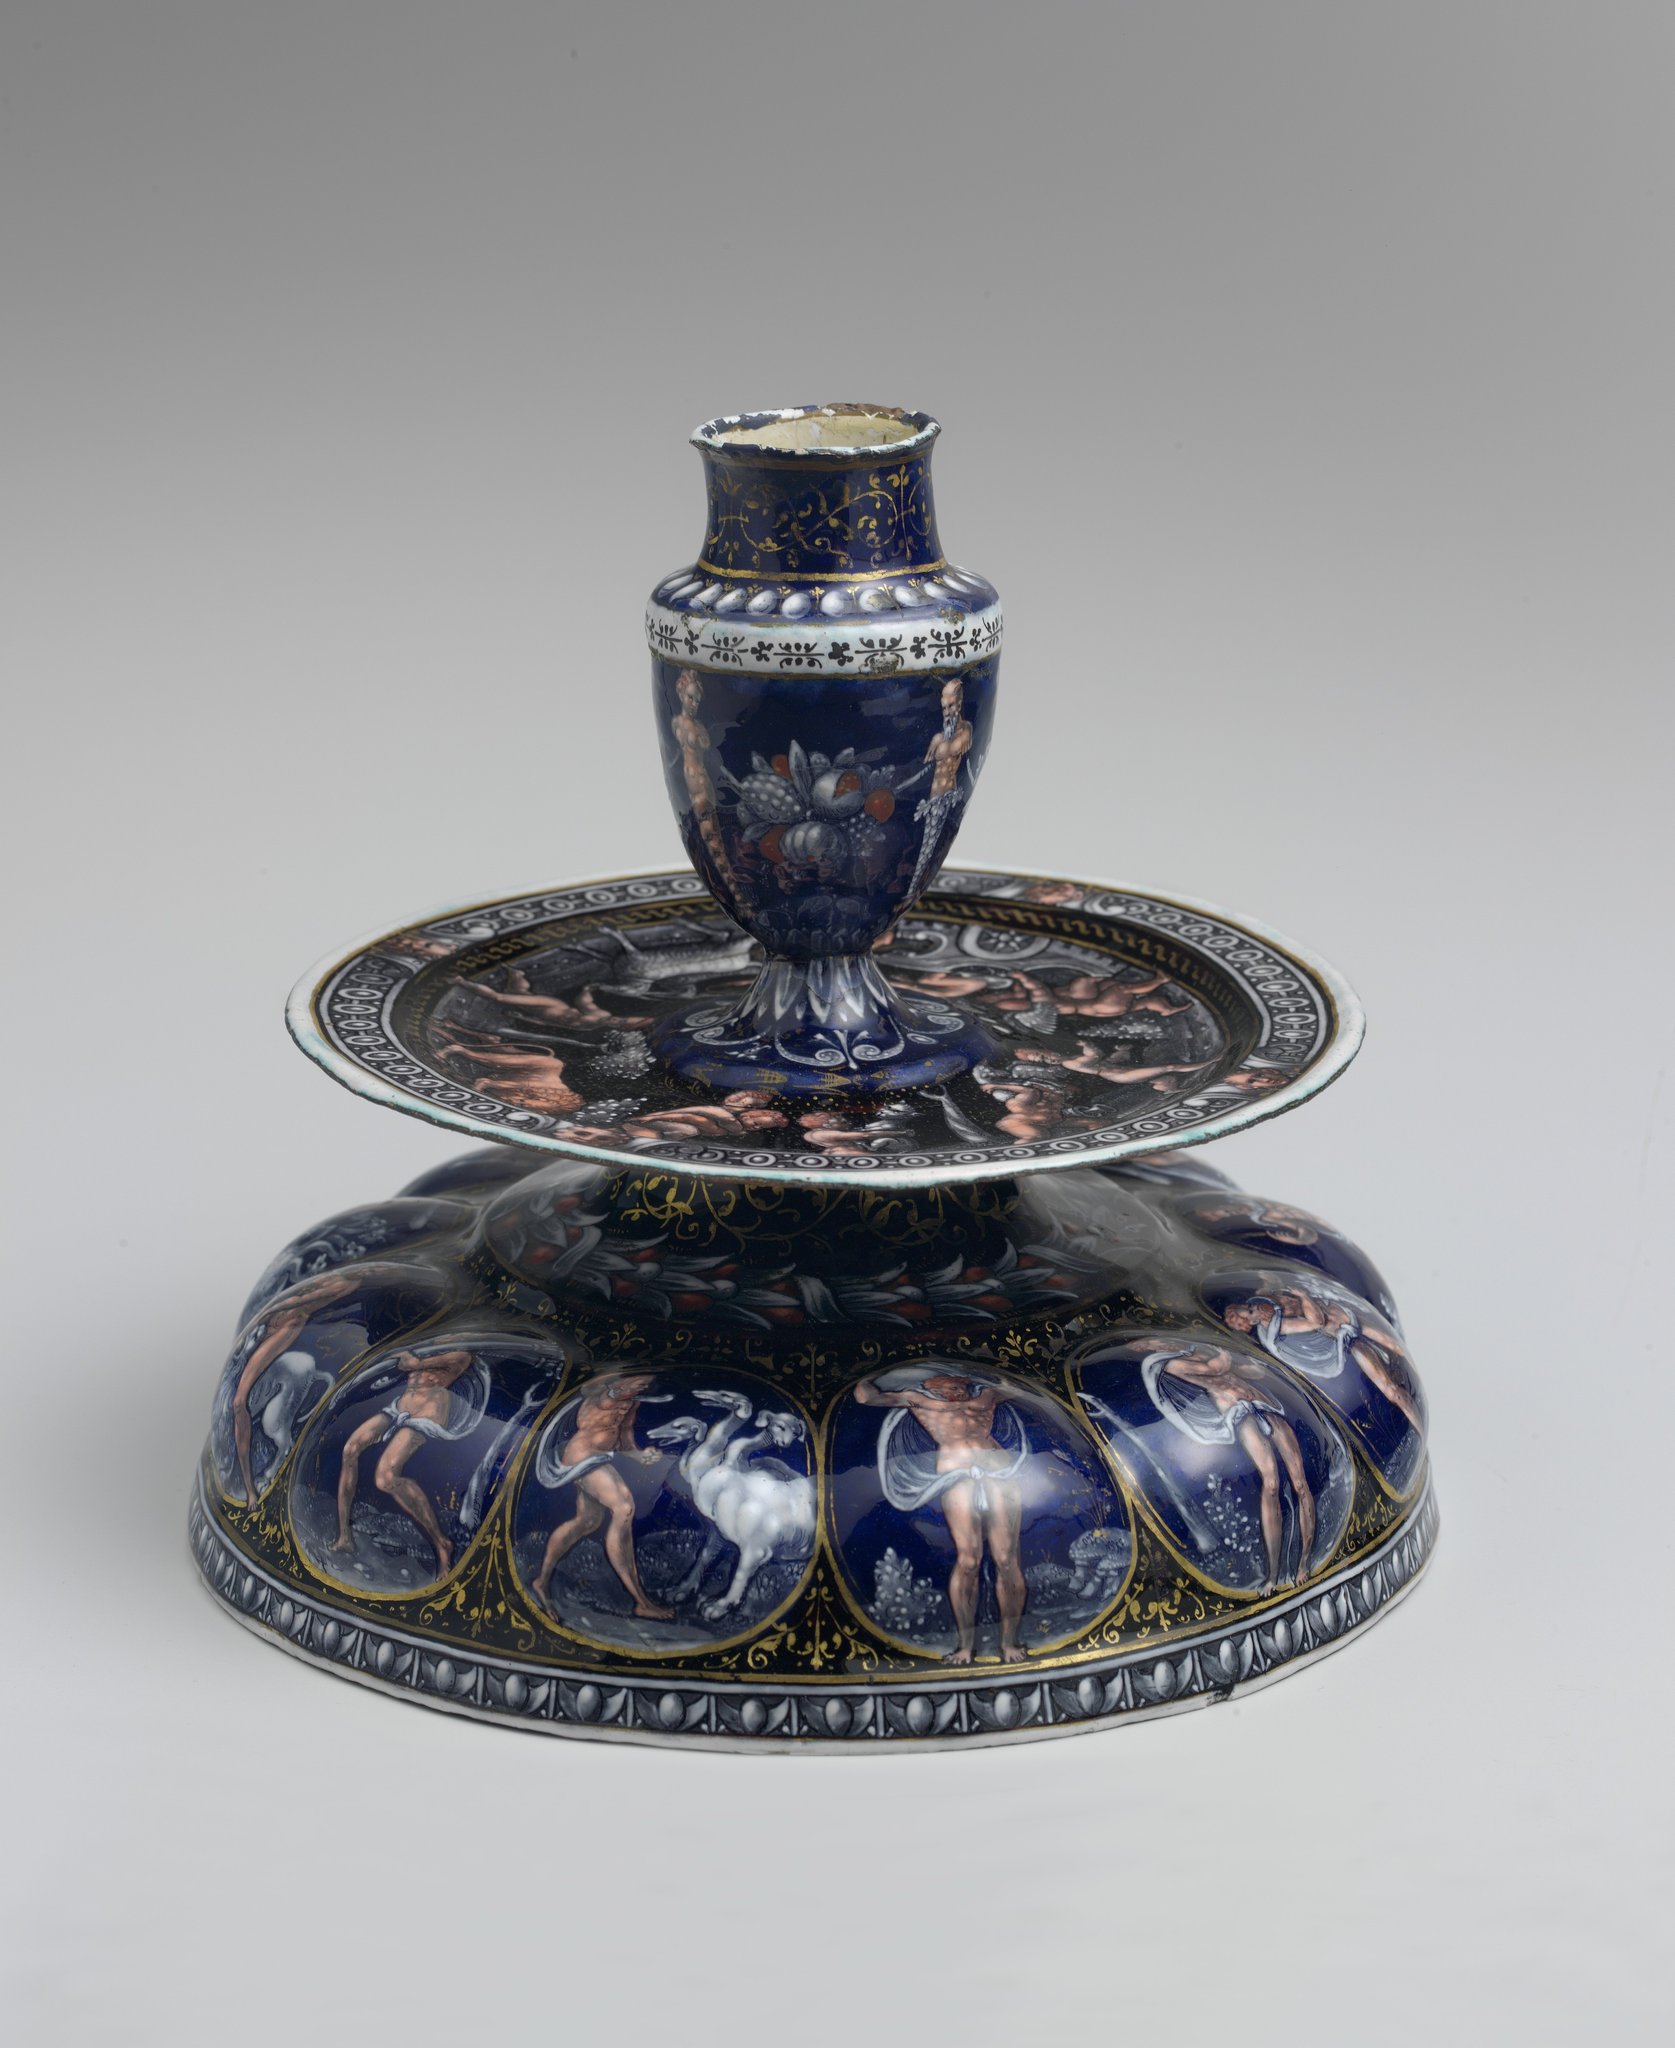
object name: candlestick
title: Candlestick (one of a pair)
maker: master i. c. (probably jean court or jean de court)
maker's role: artist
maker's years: 1550-1599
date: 1560-1570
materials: copper, enamel, gilt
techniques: painting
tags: animals,hercules